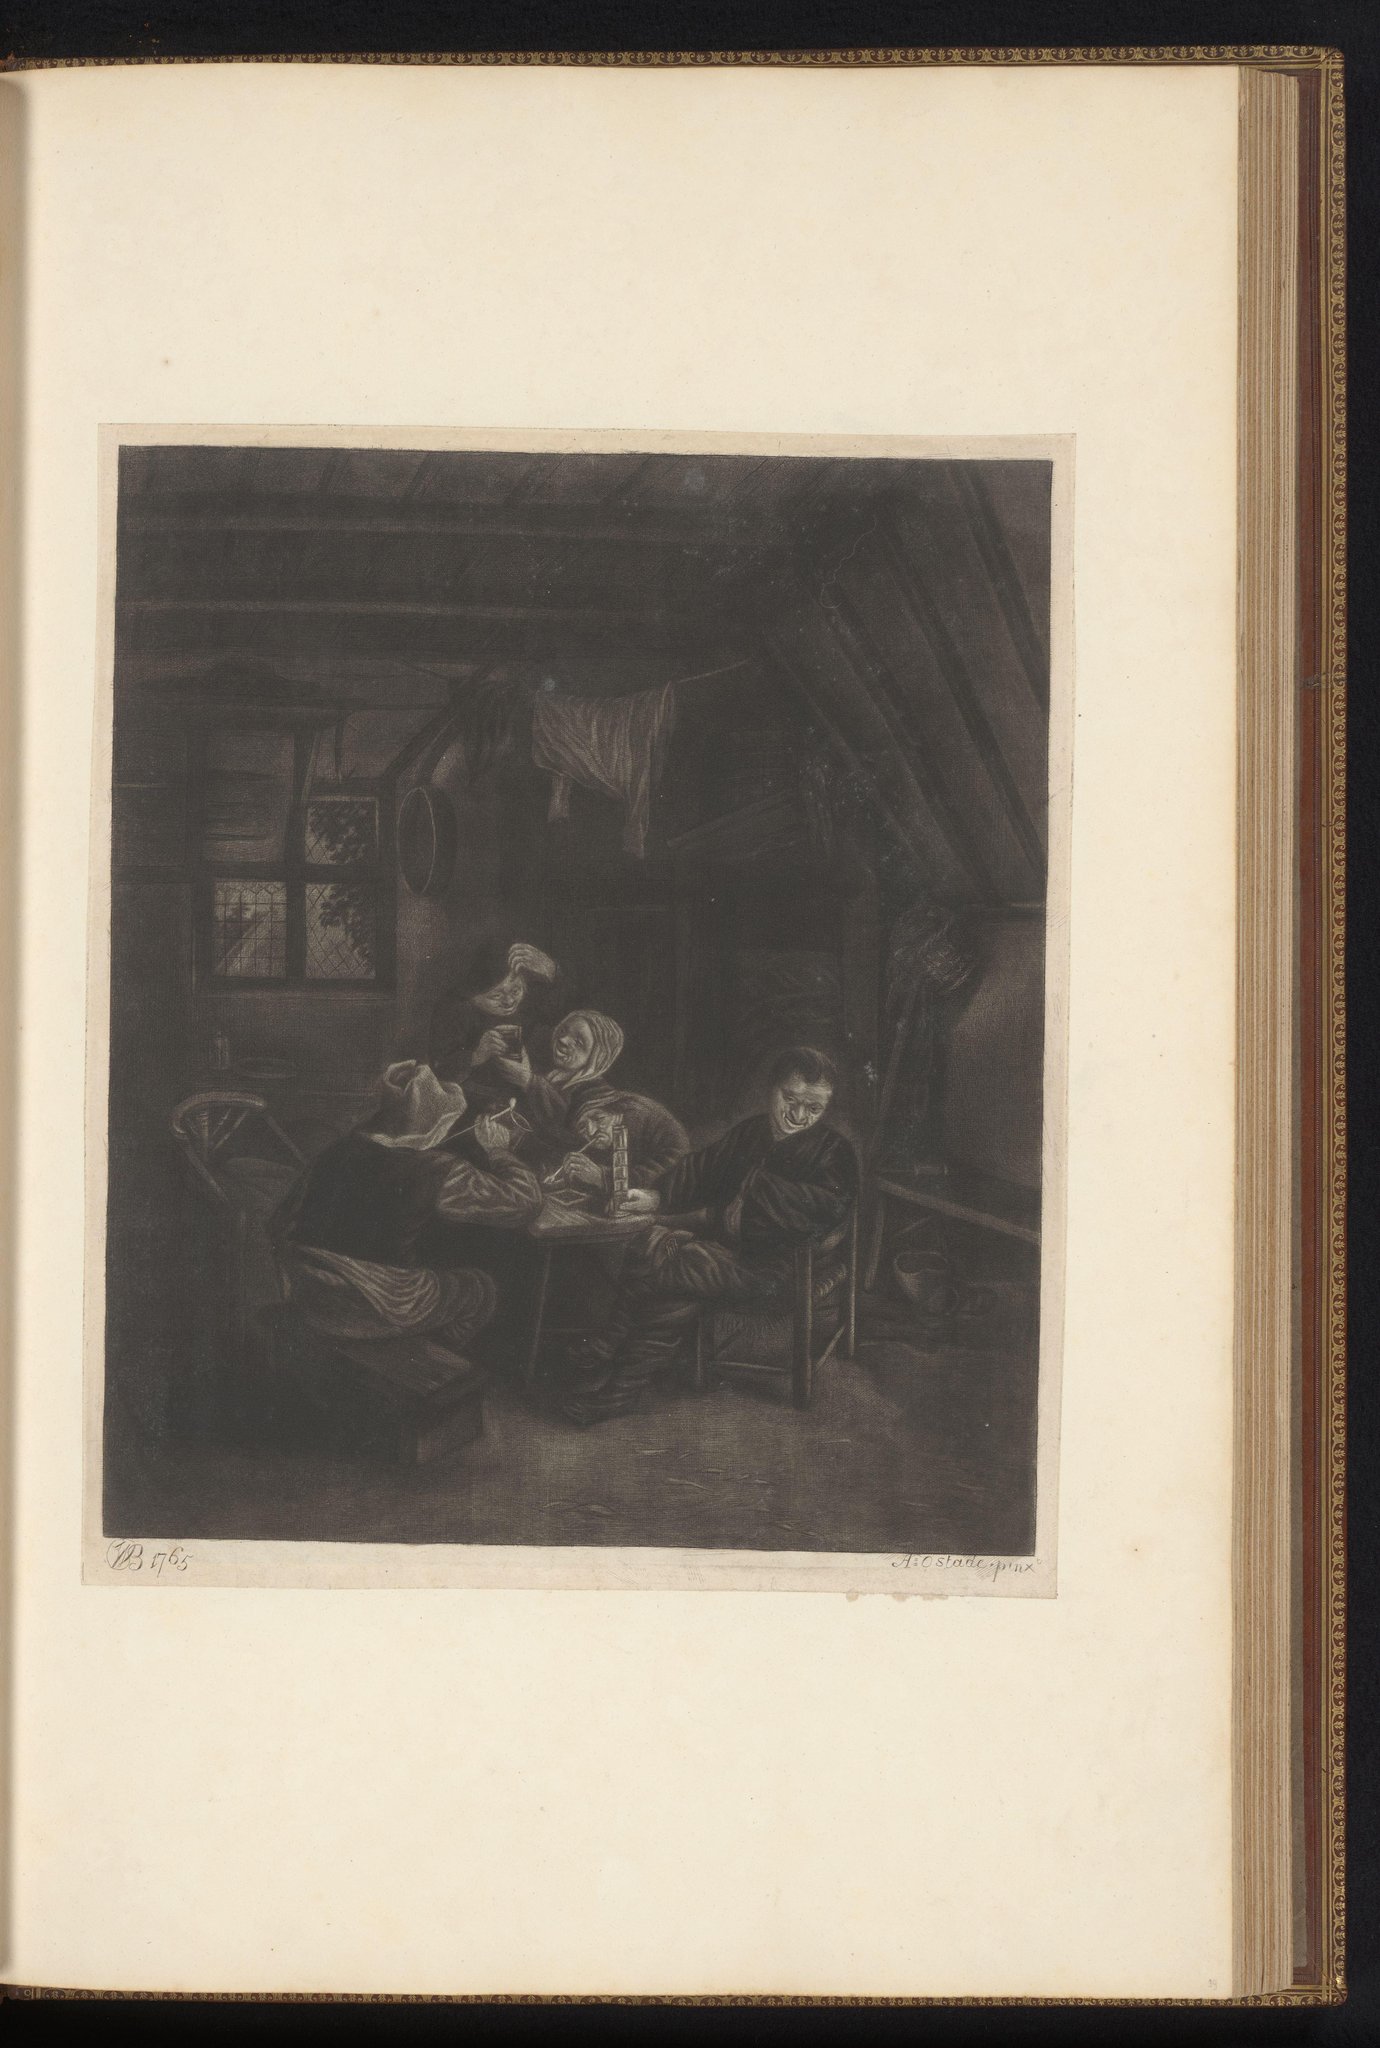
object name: album leaf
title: Boereninterieur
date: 1765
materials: paper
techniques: etching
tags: pipe ~ tobacco, farmers, drinking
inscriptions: date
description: Een interieur met vijf boeren aan een tafel. Twee mannen roken een pijp. De prent maakt deel uit van een album.